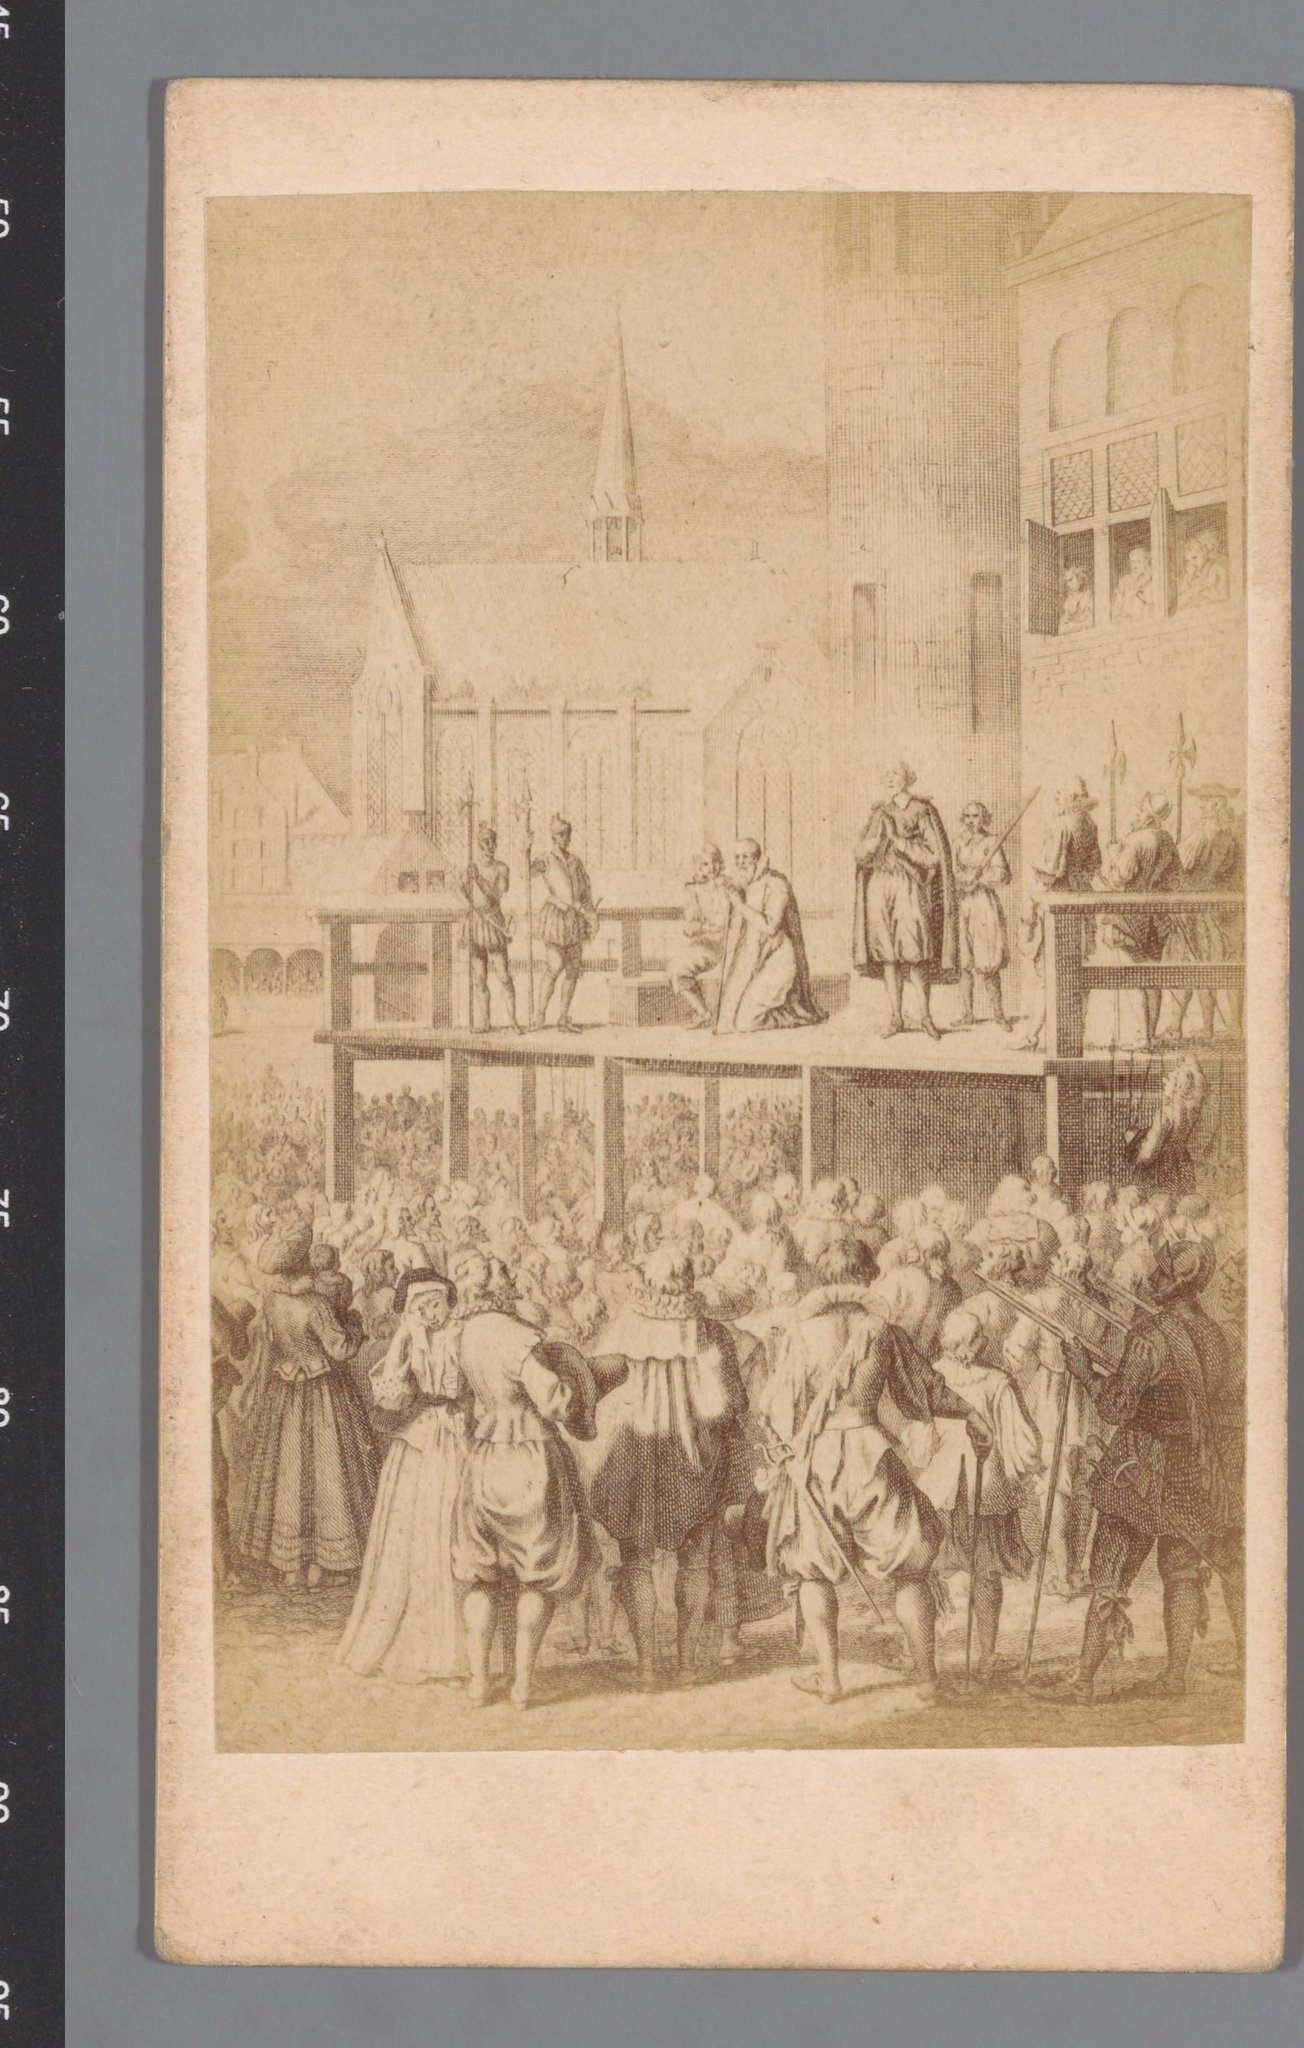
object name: carte de visite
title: Fotoreproductie van een gravure van de executie van Johan van Oldenbarnevelt op 13 mei 1619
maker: Anonymous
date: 1850-1900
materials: cardboard, photographic support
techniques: albumen print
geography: netherlands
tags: the hague, johan van oldenbarnevelt, on the scaffold or place of execution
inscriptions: inscription: ‘Executie van (...) genadig. Amen."’, number: ‘45’, number: ‘45’